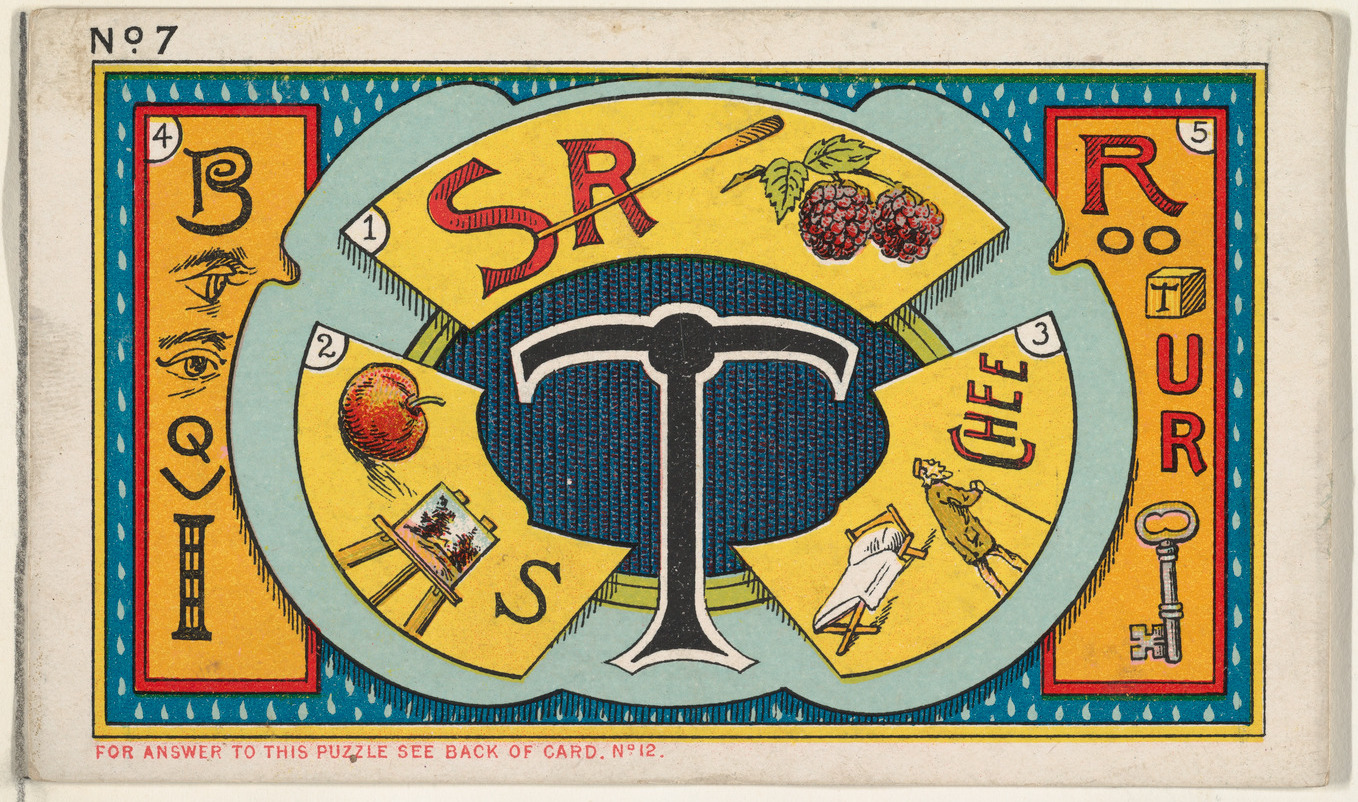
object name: print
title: Puzzle Card Number 7, Tea Puzzle, from the Jokes series (N118) issued by Duke Sons & Co. to promote Honest Long Cut Tobacco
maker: w. duke, sons & co.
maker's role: publisher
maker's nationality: american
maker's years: 1870-1920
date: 1890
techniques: color lithograph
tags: games